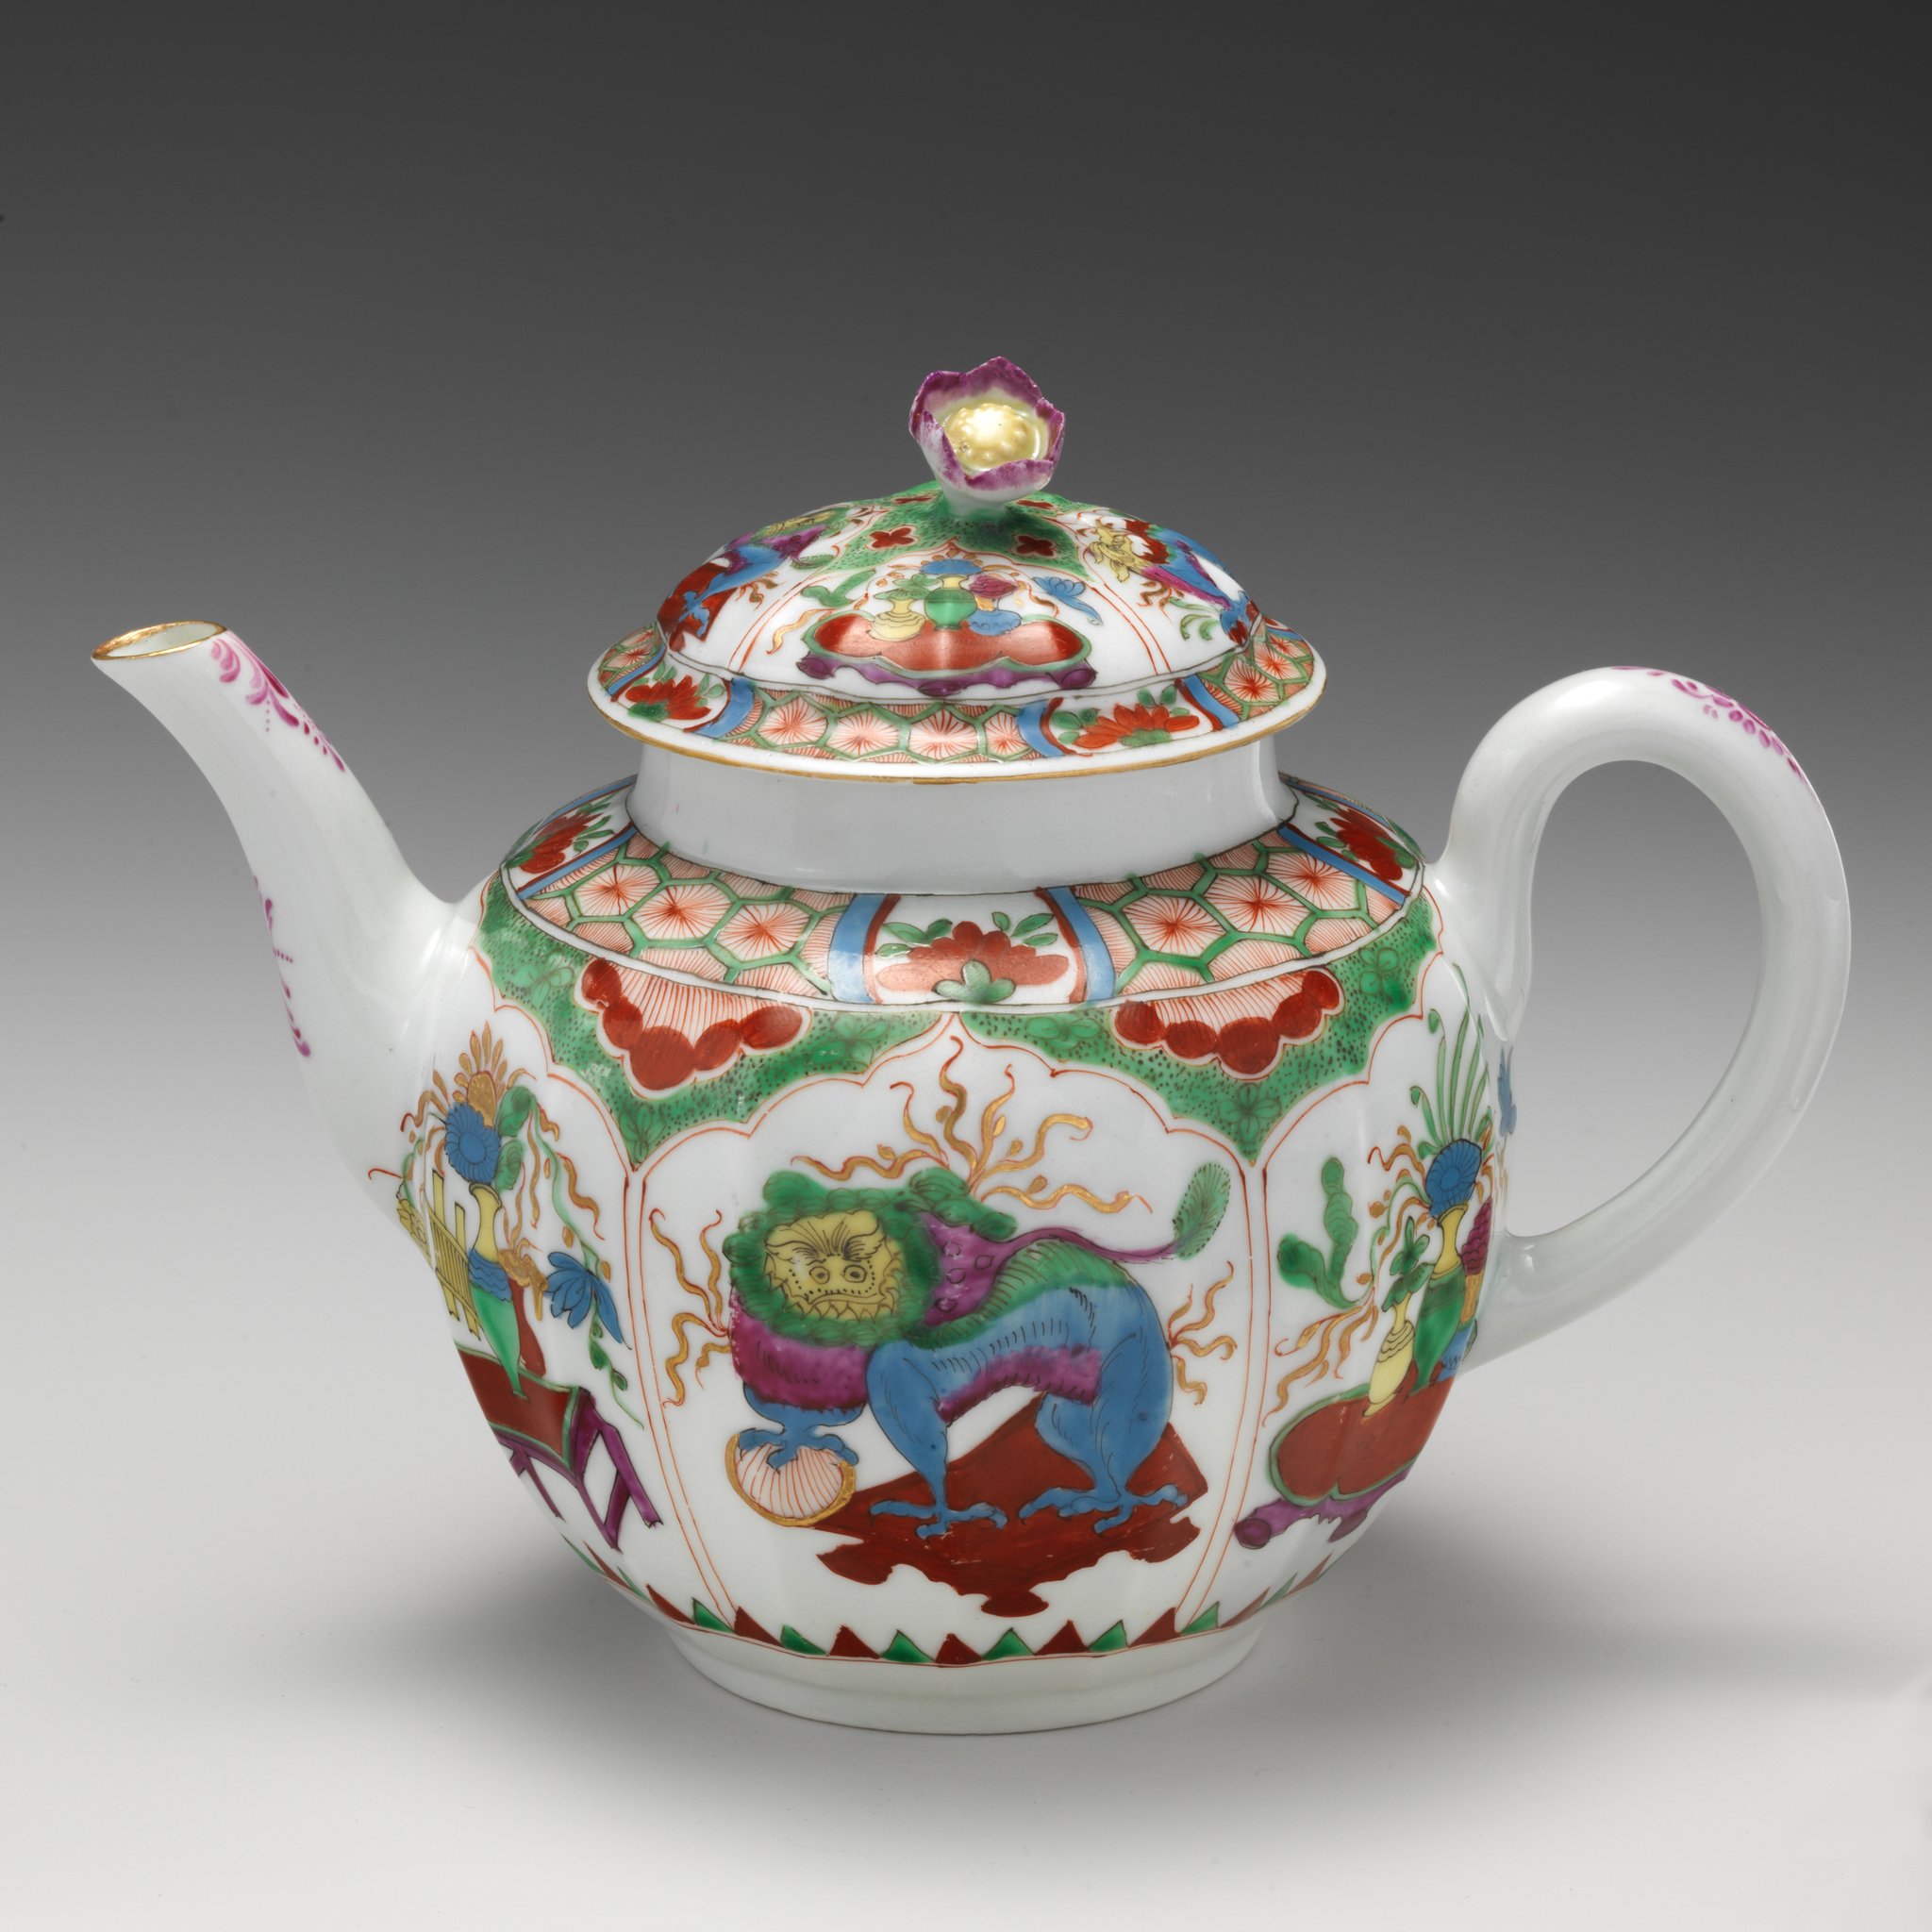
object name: teapot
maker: worcester factory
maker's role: factory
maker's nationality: british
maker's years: 1751-2008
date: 1770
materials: enamel, soft paste porcelain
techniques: gilding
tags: mythical creatures,lions